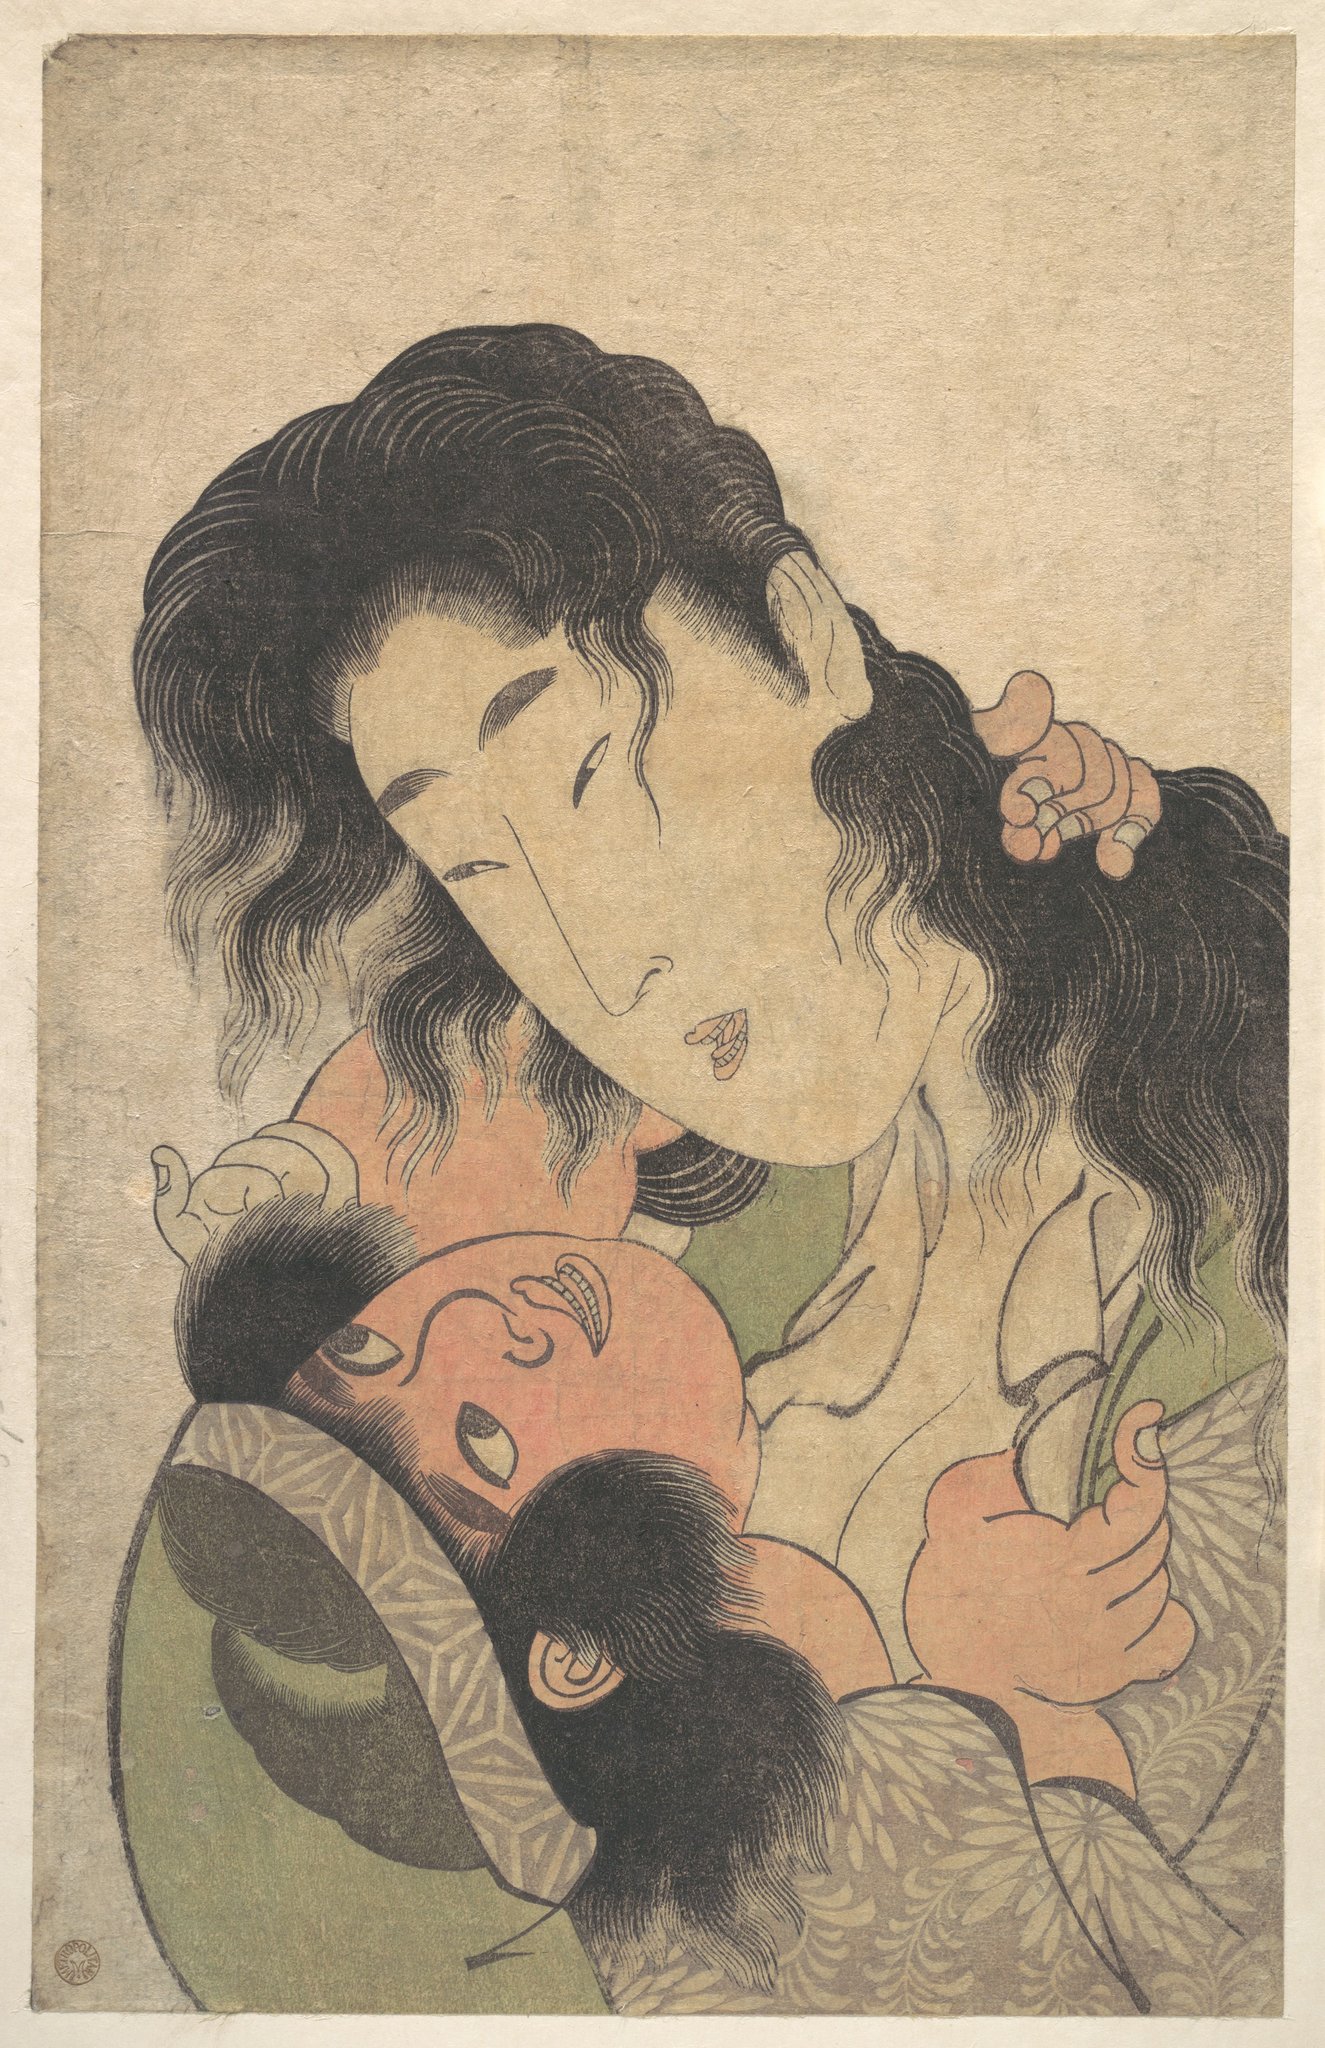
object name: print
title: Yamauba Playing with Kintarō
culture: japanese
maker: kitagawa utamaro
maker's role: artist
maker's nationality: japanese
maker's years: 1754-1806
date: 1795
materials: ink, paper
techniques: nishiki e, woodblock print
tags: children,women,playing